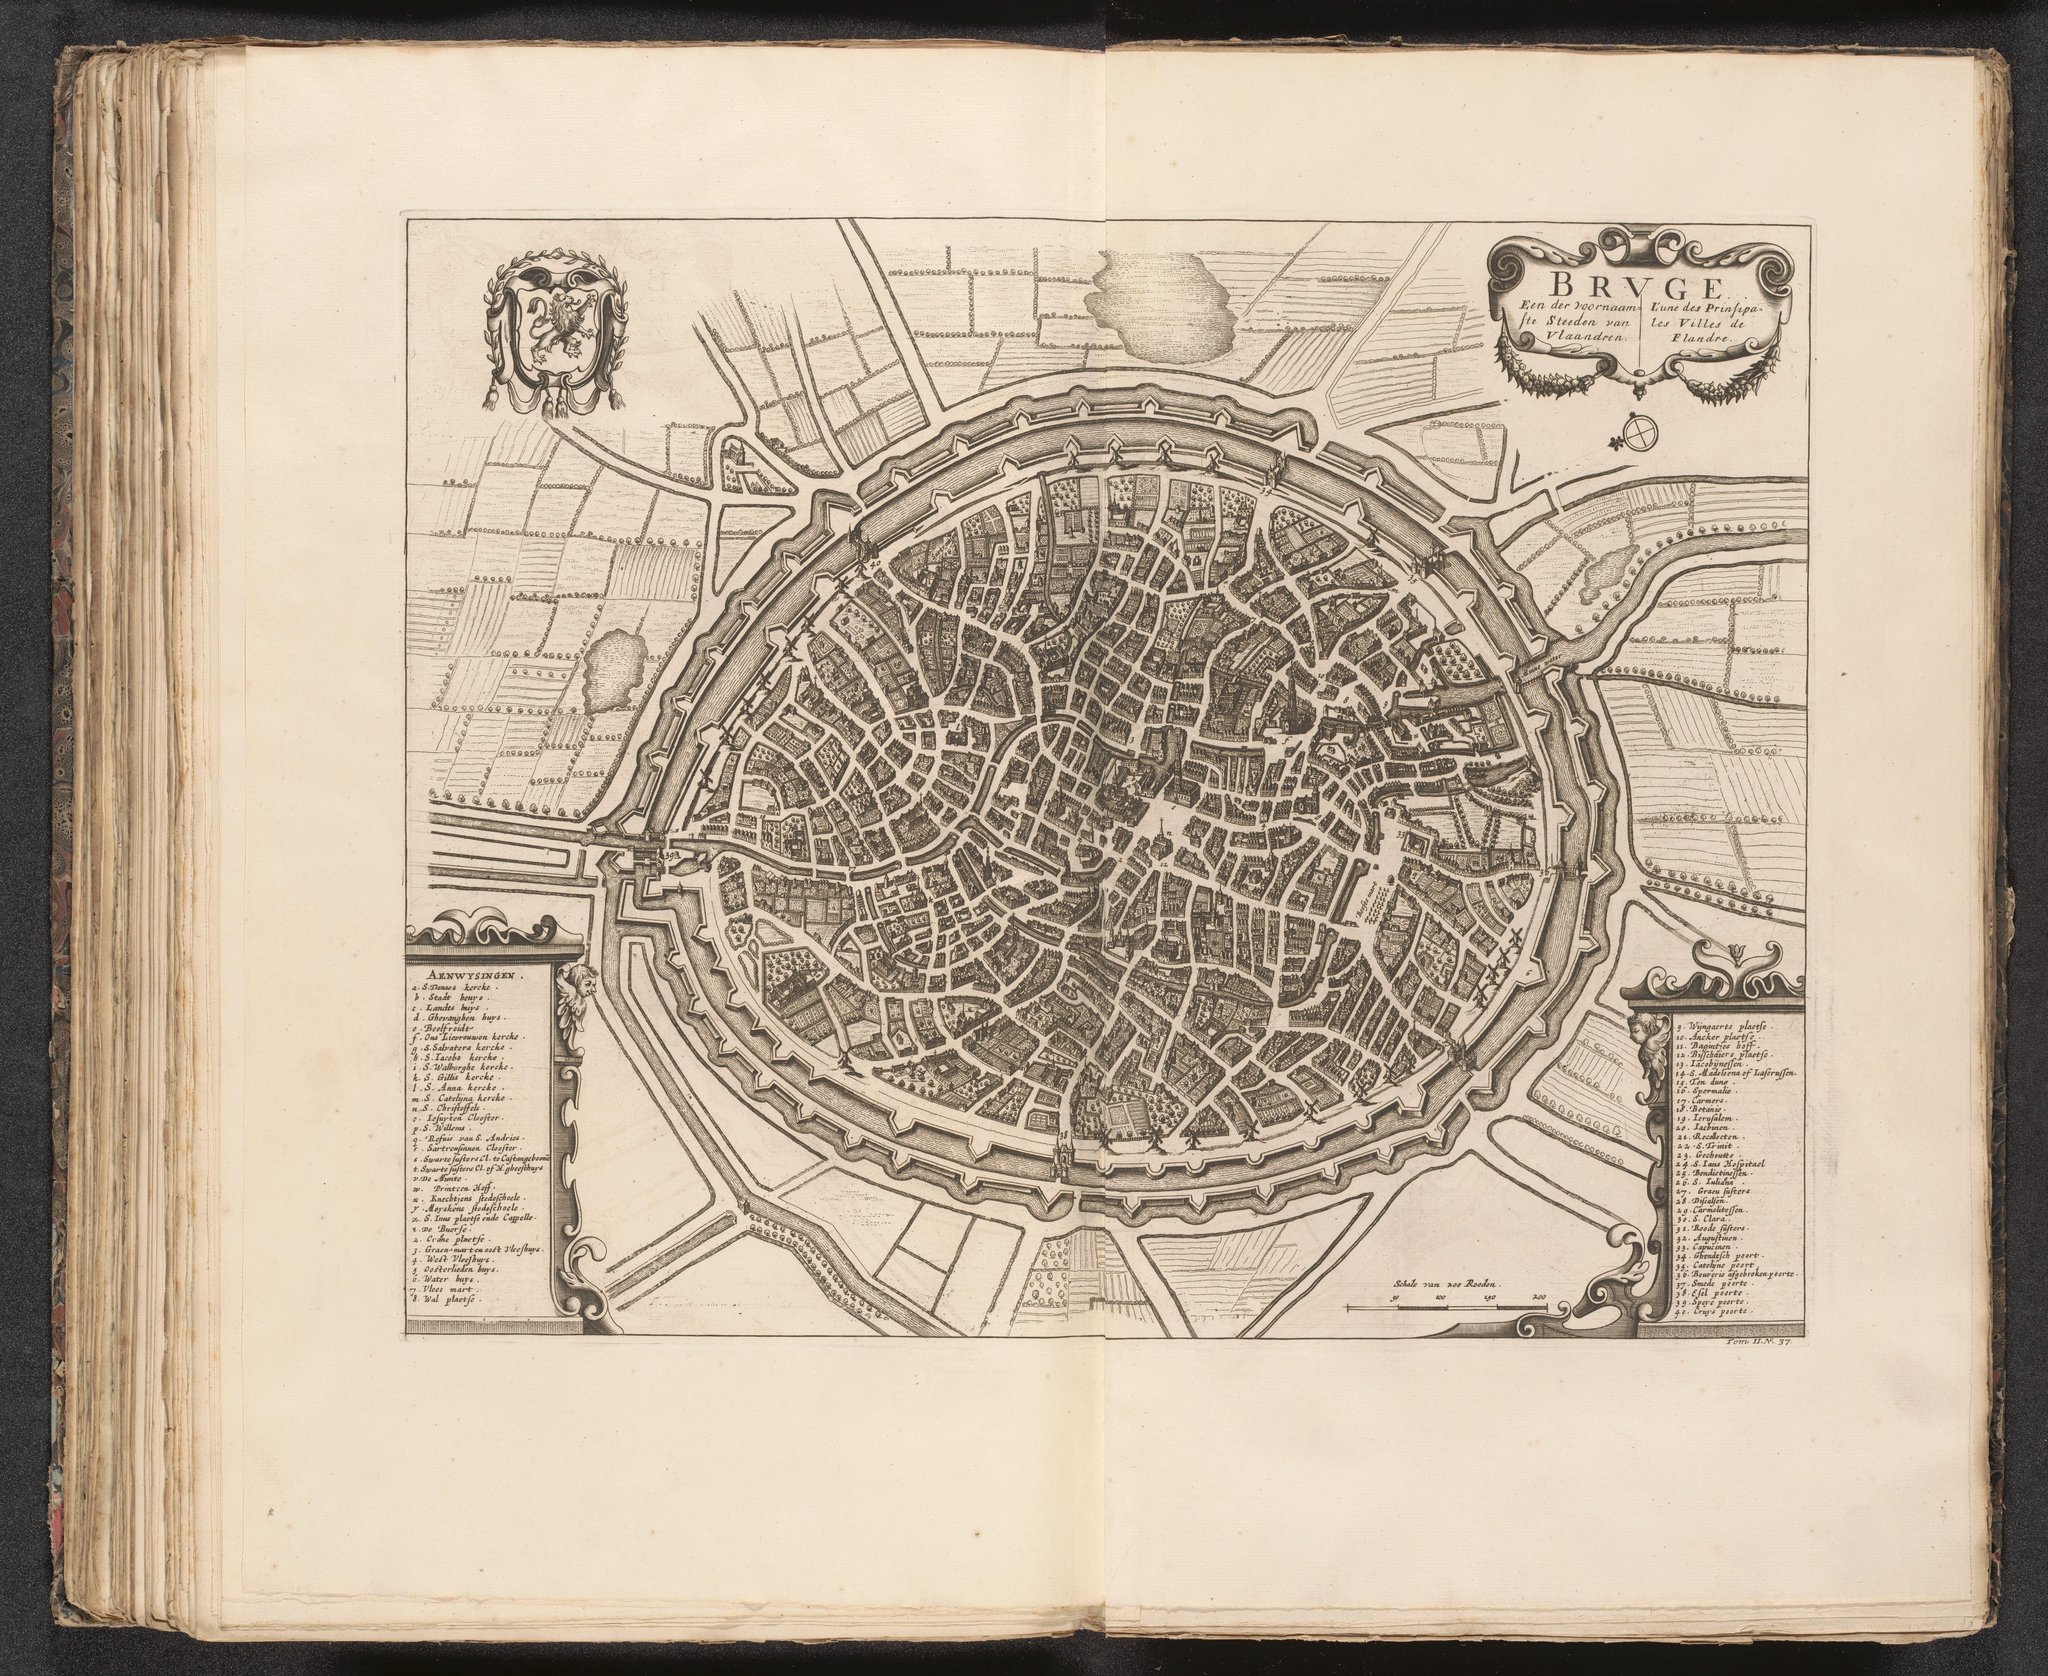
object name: map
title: Bruge Een der voornaamste Steeden van Vlaanderen / [Bruge] L'une des Principales Villes de Flandre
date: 1600-1680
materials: paper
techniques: engraving, etching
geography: the hague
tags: johan willem friso (prins van oranje-nassau), john churchill (1e hertog van marlborough), maps of cities, bruges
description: Plattegrond van Brugge, ca. 1701-1713. Genummerd rechtsonder: Tom. II. No. 37. Illustratie in het tweede deel van : [Jean] du Mont, Oorlogskundige beschryving van de veldslagen en belegeringen, der drie ... wydvermaarde krygsoversten... den Prins Eugenius van Savoye, den ... Hertog van Marlborough, en den Prins van Oranje en Nassau-Vriesland, in de editie van 1729. Dit tweede deel is hoofdzakelijk gewijd aan de daden van de hertog van Marlborough en prins Johan Willem Friso.